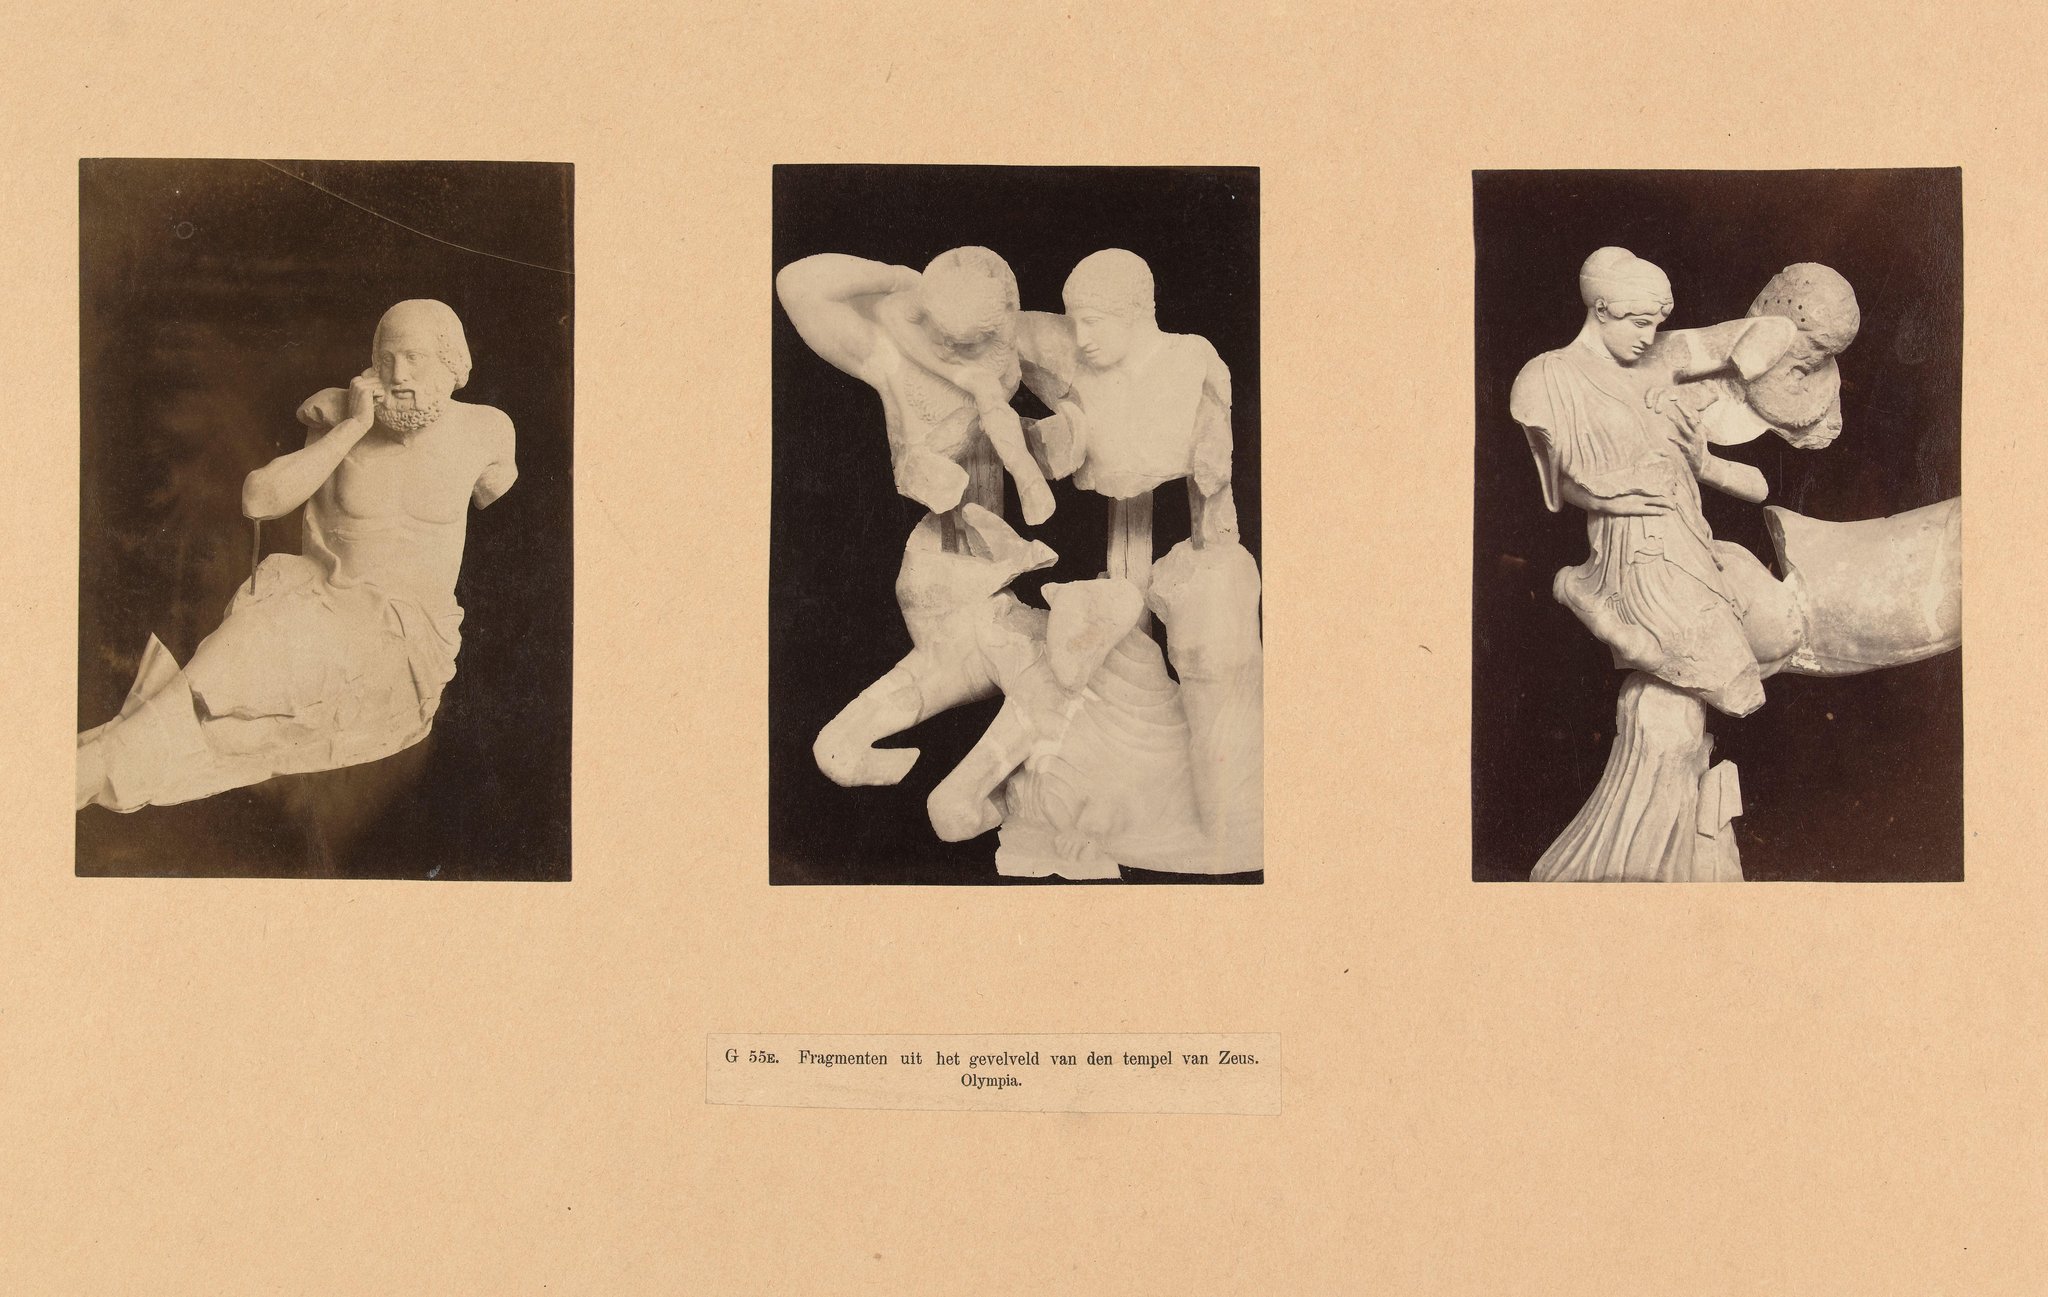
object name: photograph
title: G 55E. Fragmenten uit het gevelveld van den tempel van Zeus. Olympia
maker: Anonymous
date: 1890-1895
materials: cardboard, paper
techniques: albumen print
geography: olympia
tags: piece of sculpture, reproduction of a piece of sculpture, fighting centaurs, centauromachy (in general)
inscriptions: stamp: ‘Gemeentelijke bibliotheek/ Rotterdam’, check stamp: ‘Bristol/ L.M.’, title: ‘G 55E. Fragmenten uit het gevelveld van den tempel van Zeus./ Olympia.’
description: Onderdeel van een groep door fotograaf Richard Polak op reis verzamelde foto’s. Deze foto is samen met andere op zijn reizen verzamelde foto's tentoongesteld bij de Rotterdamsche Kunstkring (1895), Arti en Amicitiae te Amsterdam (1897-1898?) en Societeit 't Collegie te Kampen (datum vooralsnog onbekend).